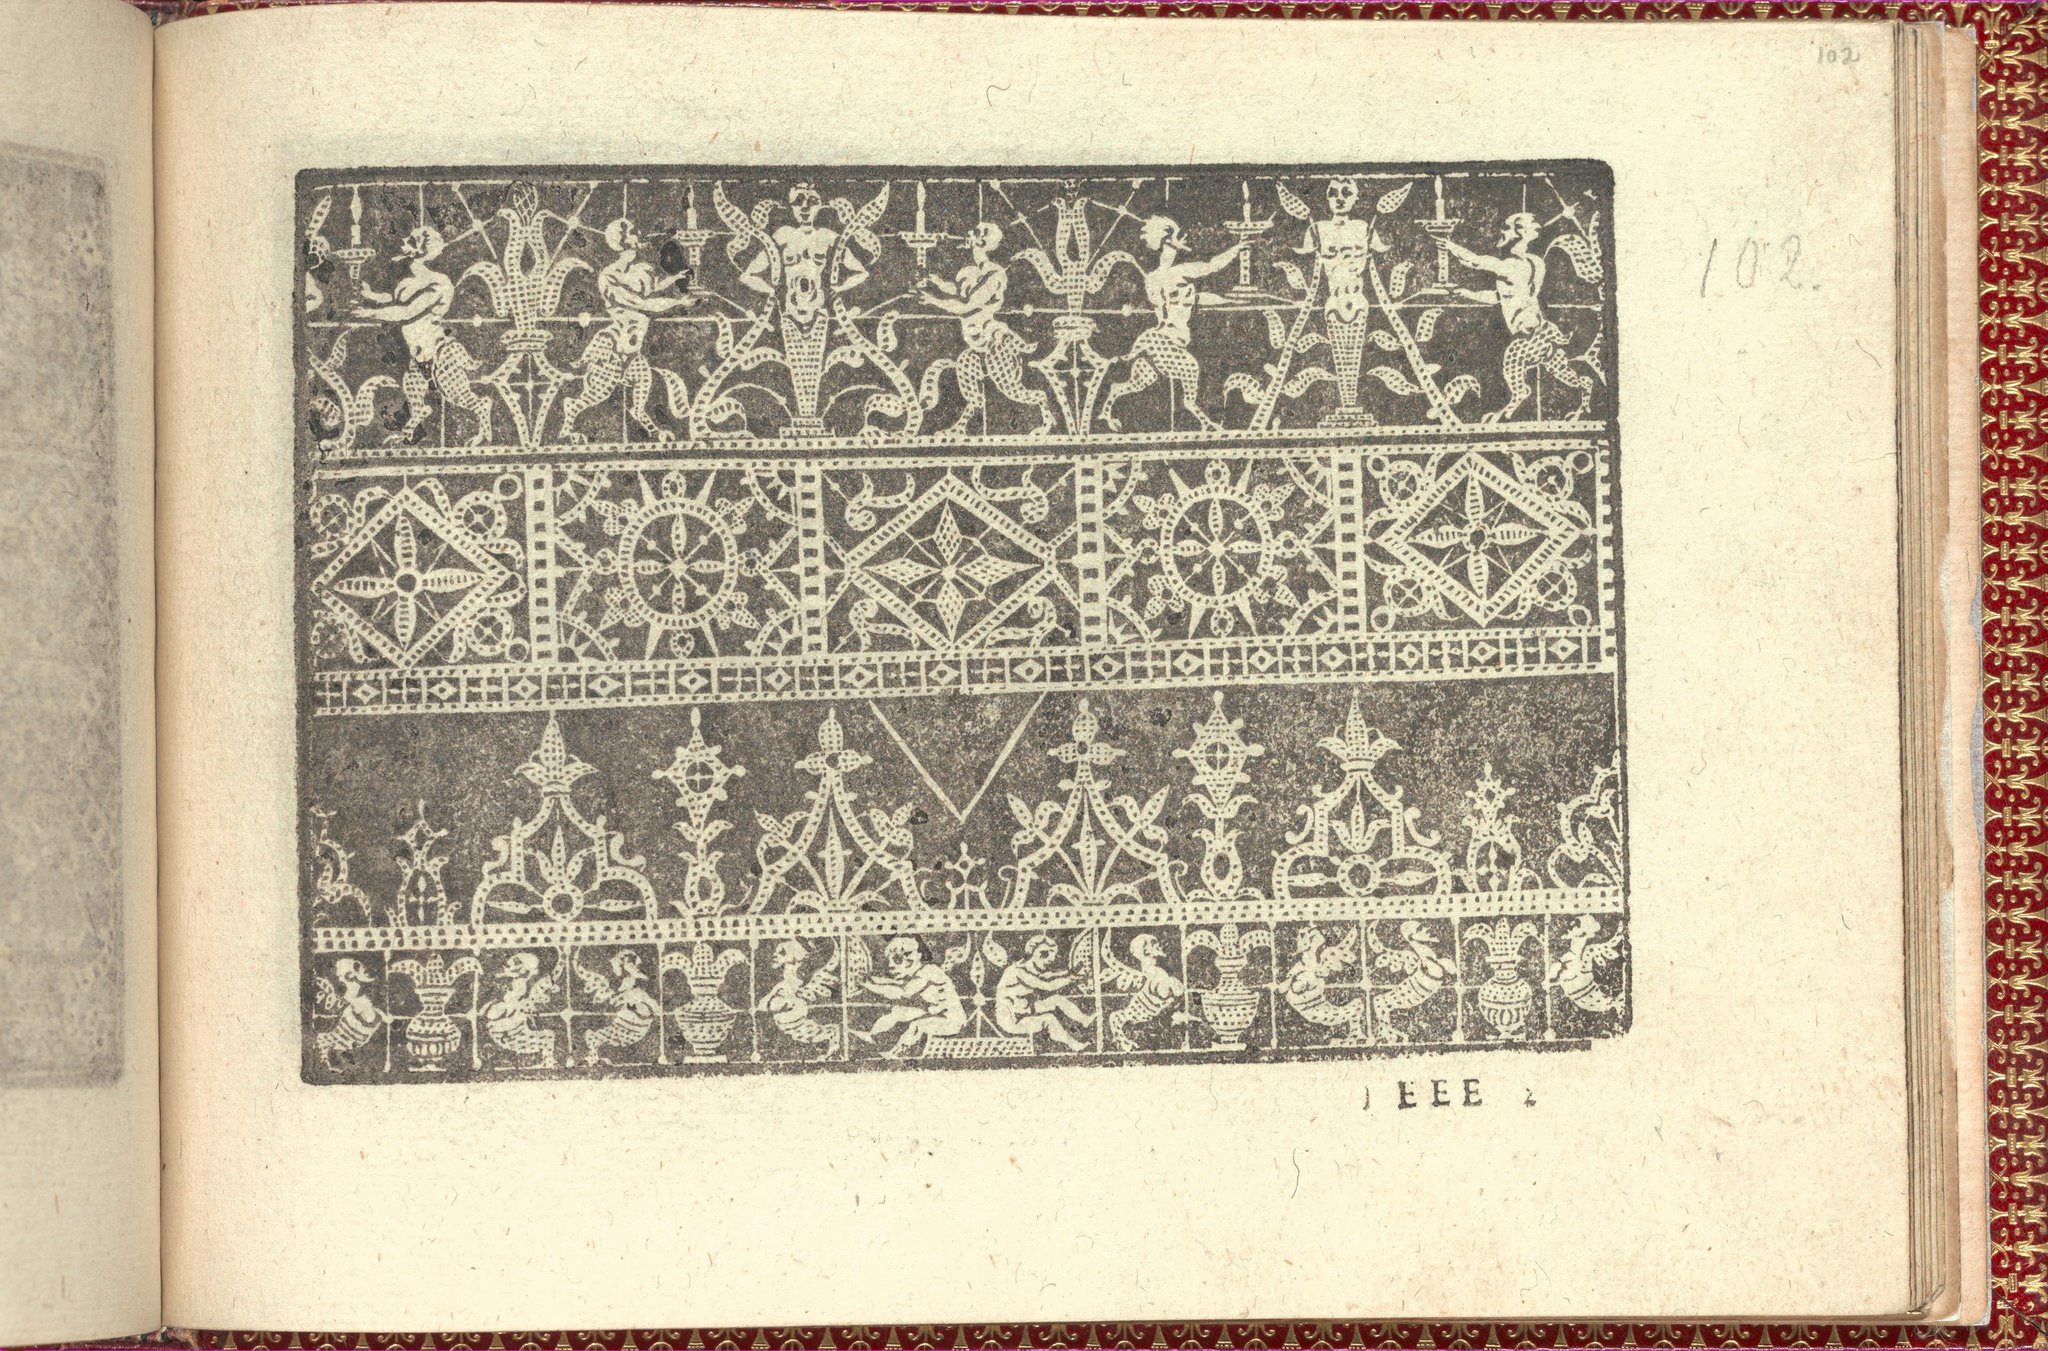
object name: book print ornament architecture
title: Corona delle Nobili et Virtuose Donne: Libro I-IV, page 102 (recto)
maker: cesare vecellio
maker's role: publisher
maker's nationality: italian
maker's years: 1521-1601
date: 1601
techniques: woodcut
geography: italy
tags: ornament,putti,satyrs